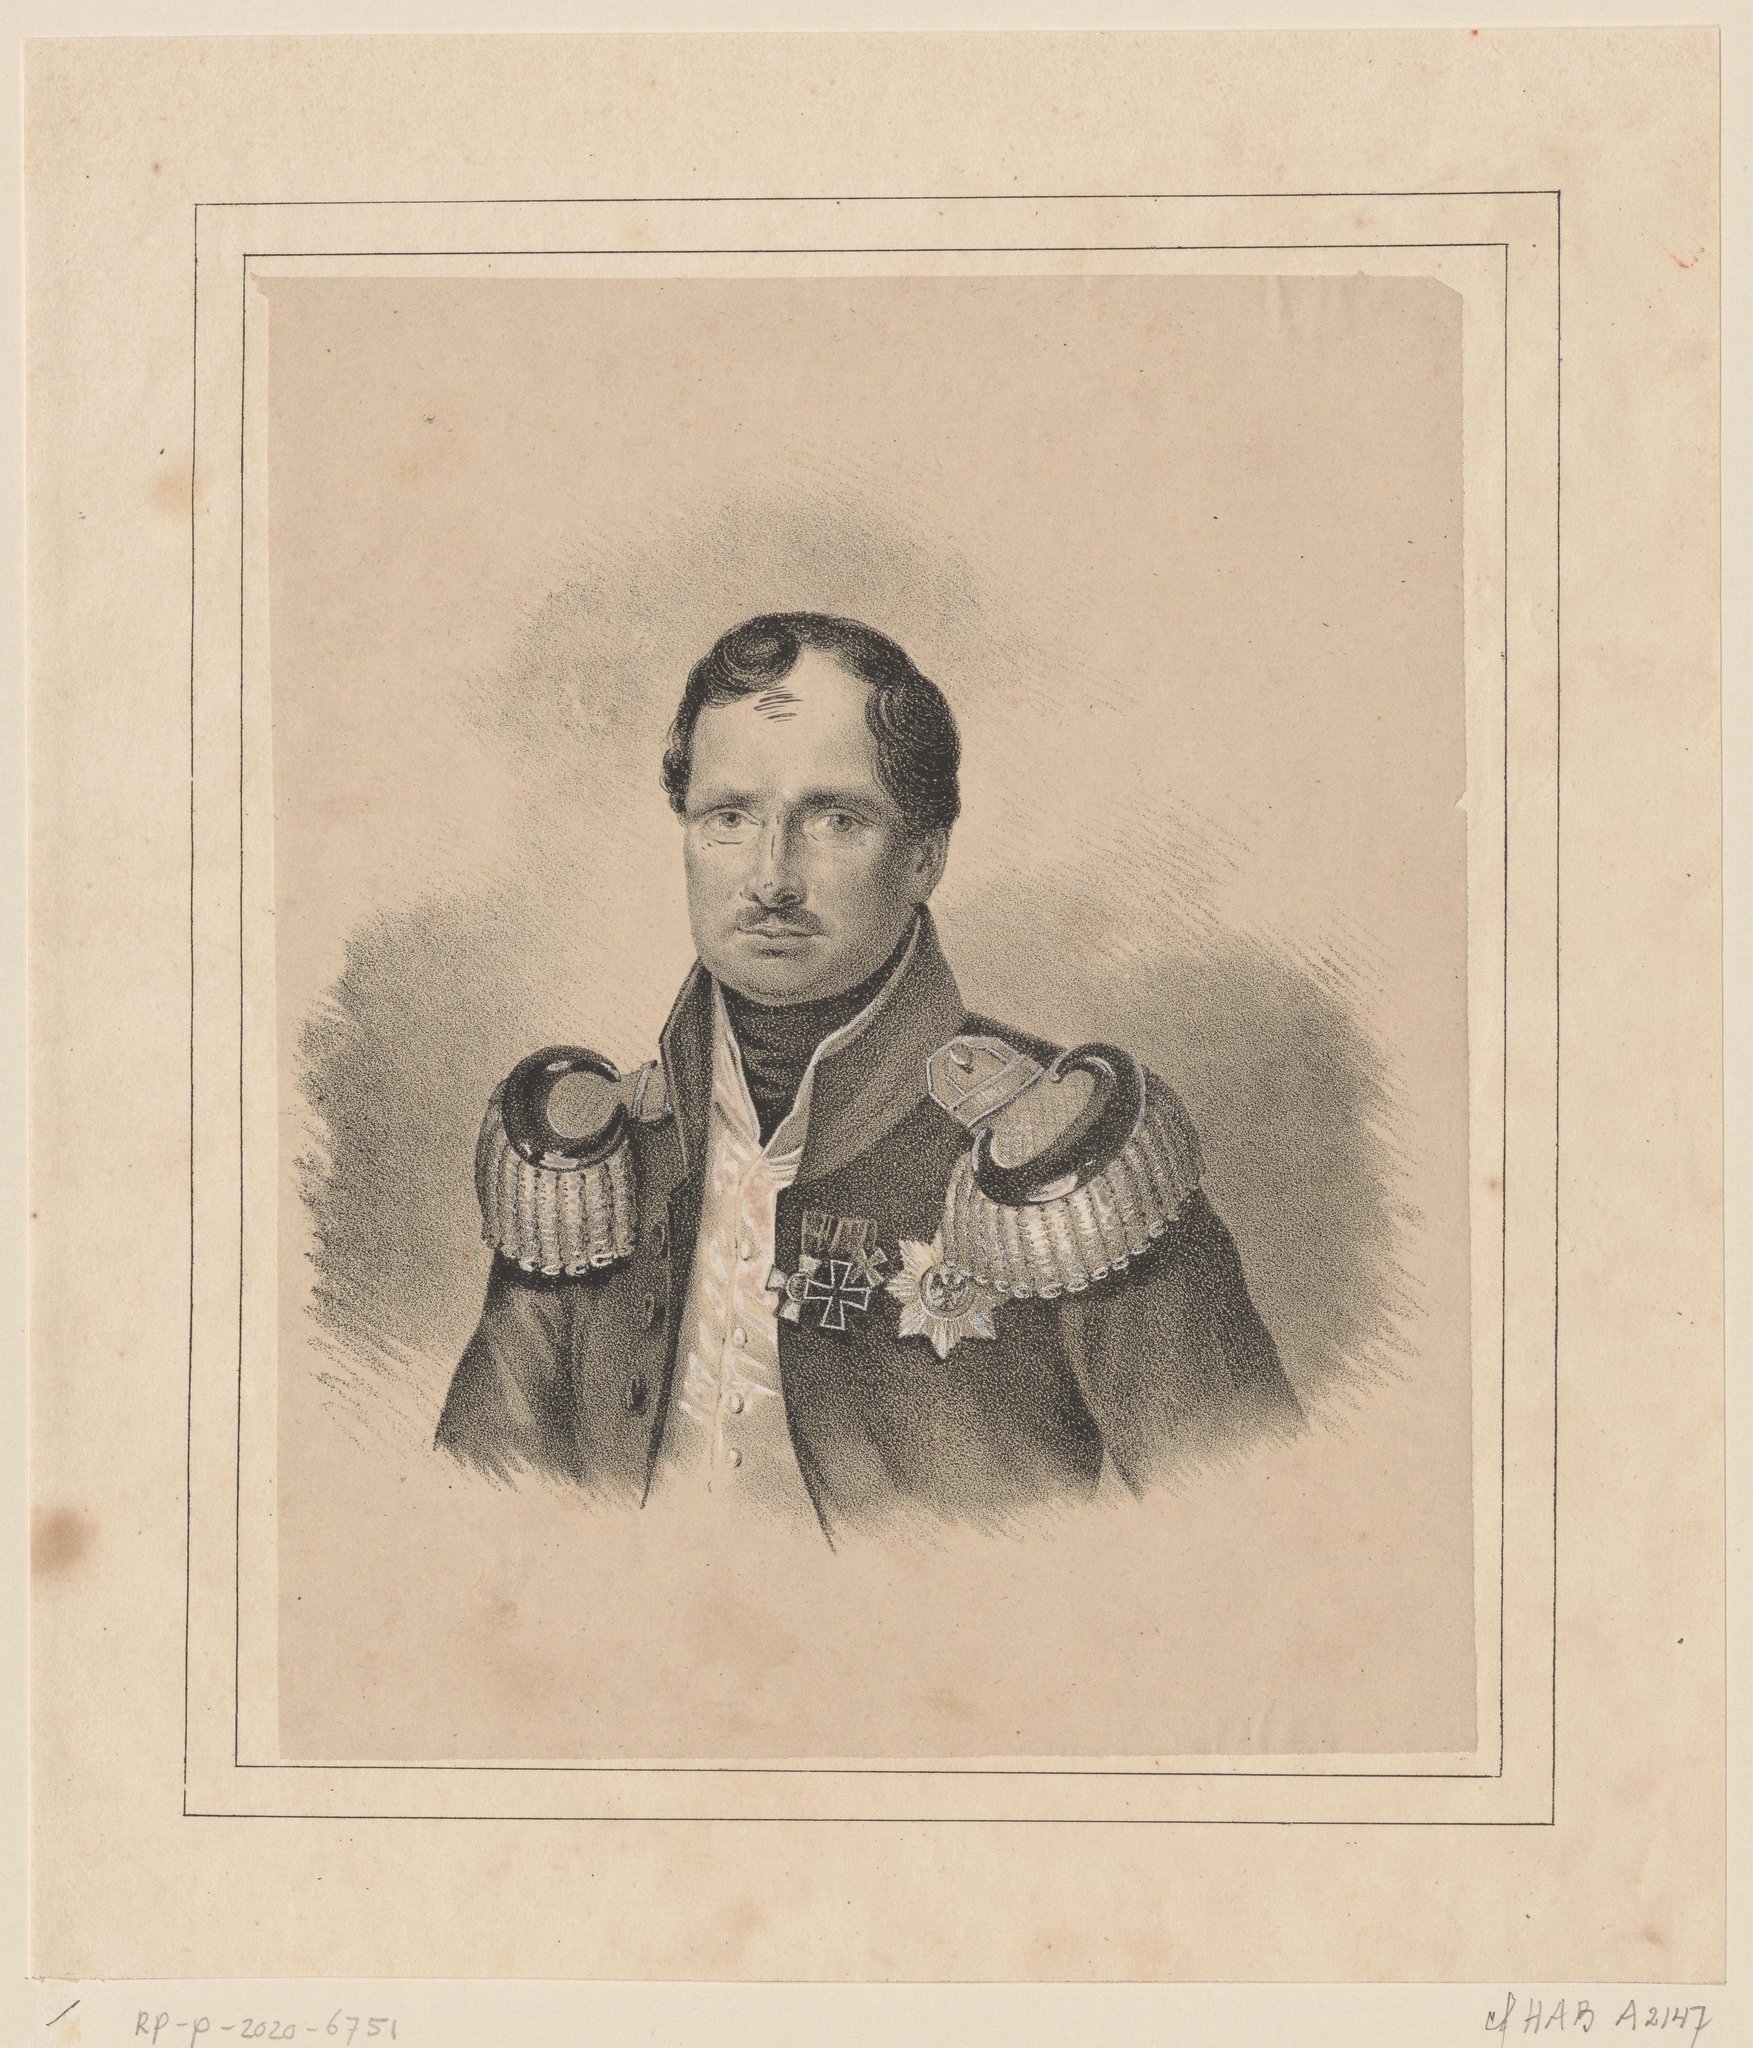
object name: print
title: Portret van Frederik Willem III van Pruisen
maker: Anonymous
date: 1800-1850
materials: paint, ink, paper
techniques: brush, lithograph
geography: germany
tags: frederik willem iii koning van pruisen, historical persons, (military) uniforms, king